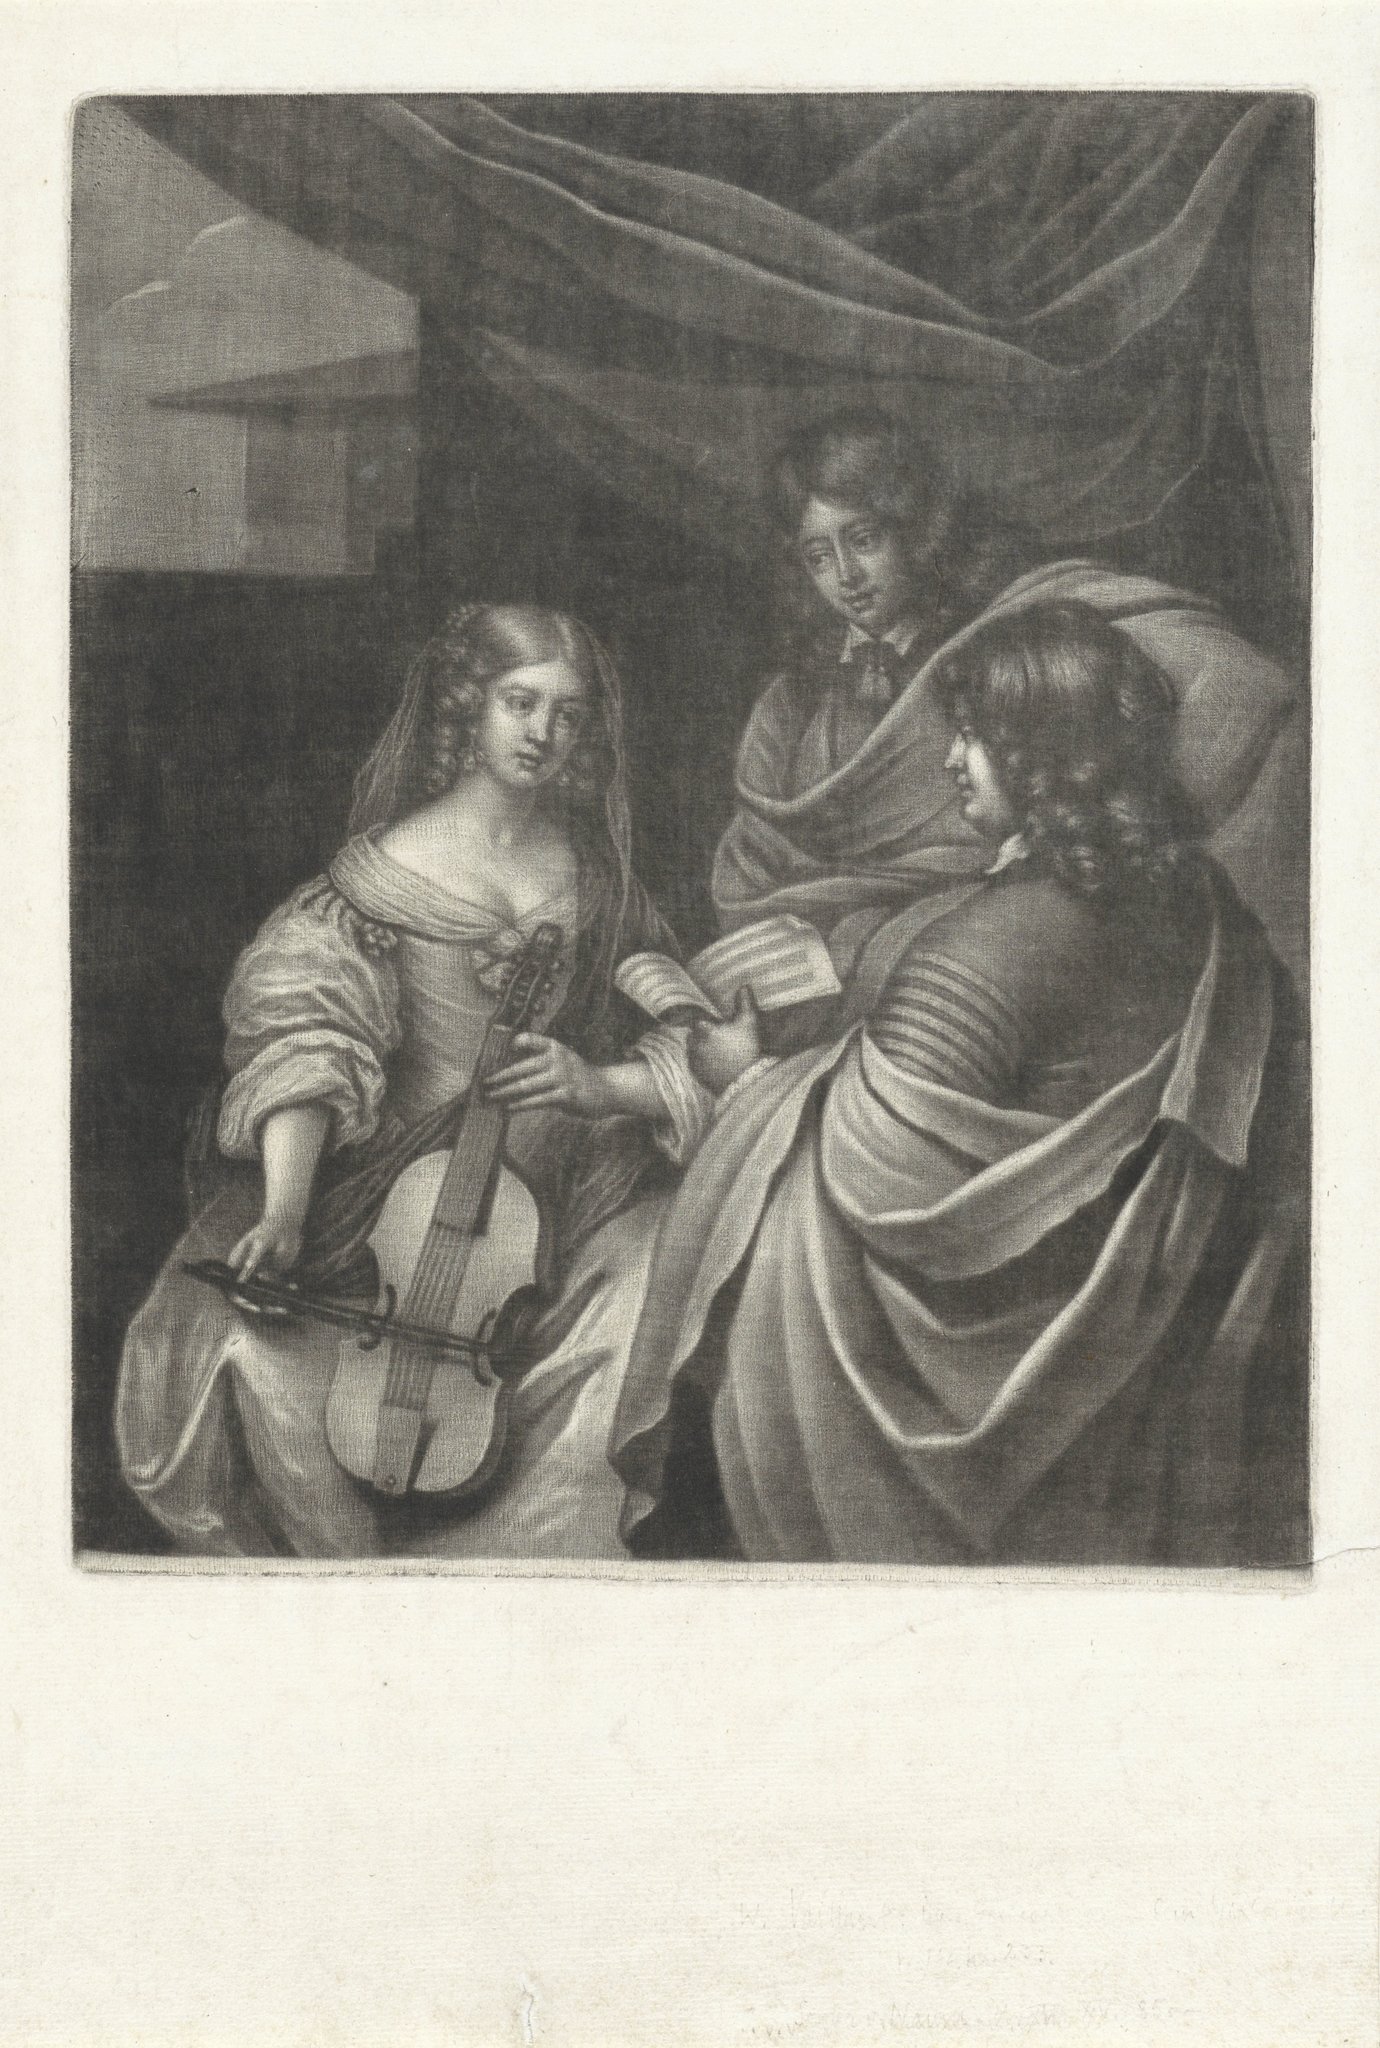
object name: print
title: Meisje met een violoncel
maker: wallerant vaillant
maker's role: draughtsman, painter, print maker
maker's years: 1623-1677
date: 1658-1677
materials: paper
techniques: mezzotint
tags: viola, violoncello; double bass, printed edition of musical score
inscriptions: collector's mark: Lugt 2228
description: Een meisje speelt violoncel voor twee mannen, waarvan er één een muziekboekje in de hand heeft.